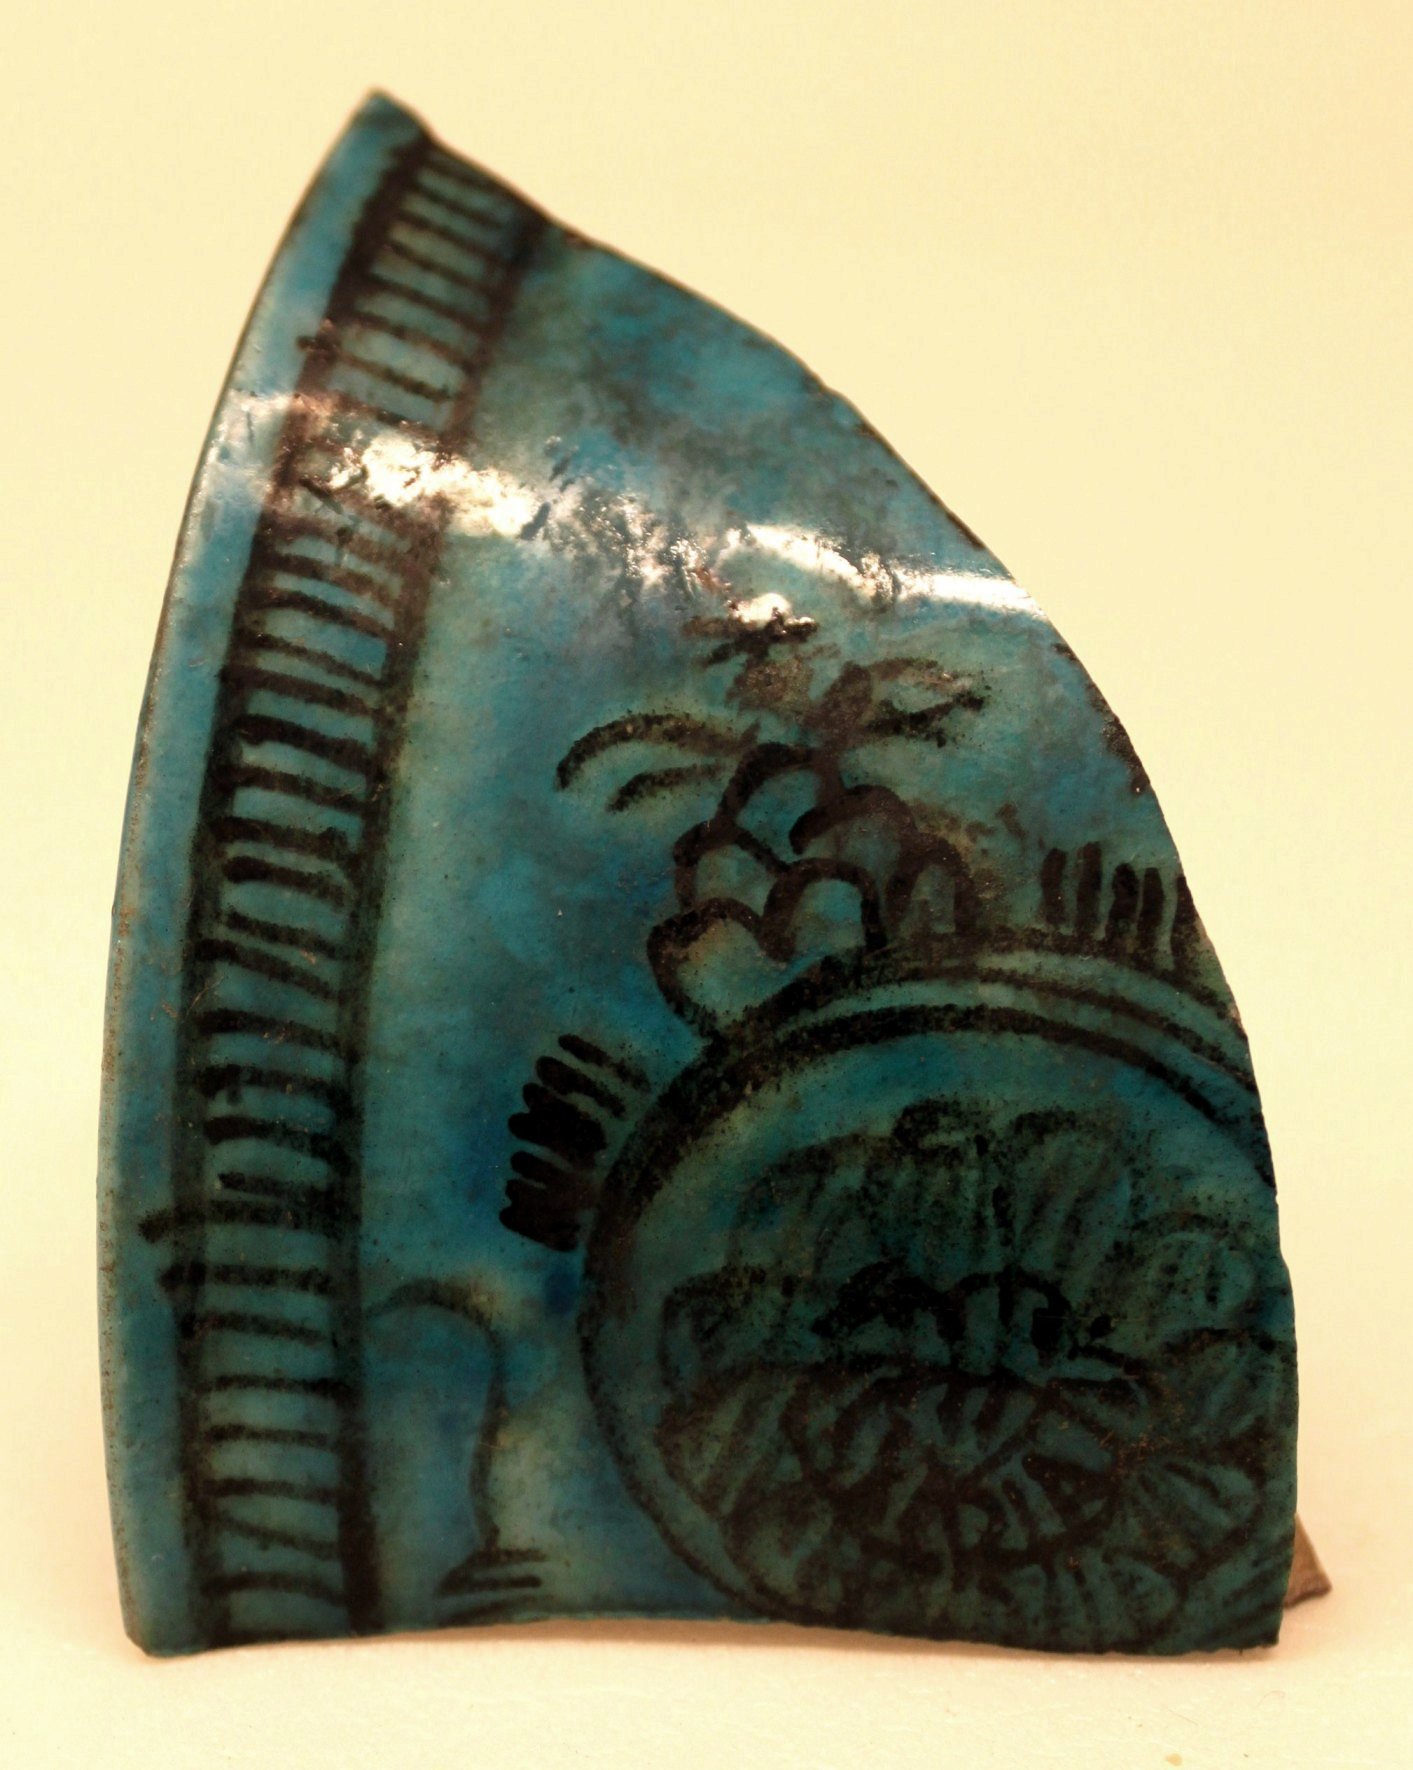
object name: fragment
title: Fragment of a Cup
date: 1601-1800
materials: glaze, stonepaste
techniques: painting, underglaze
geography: iran